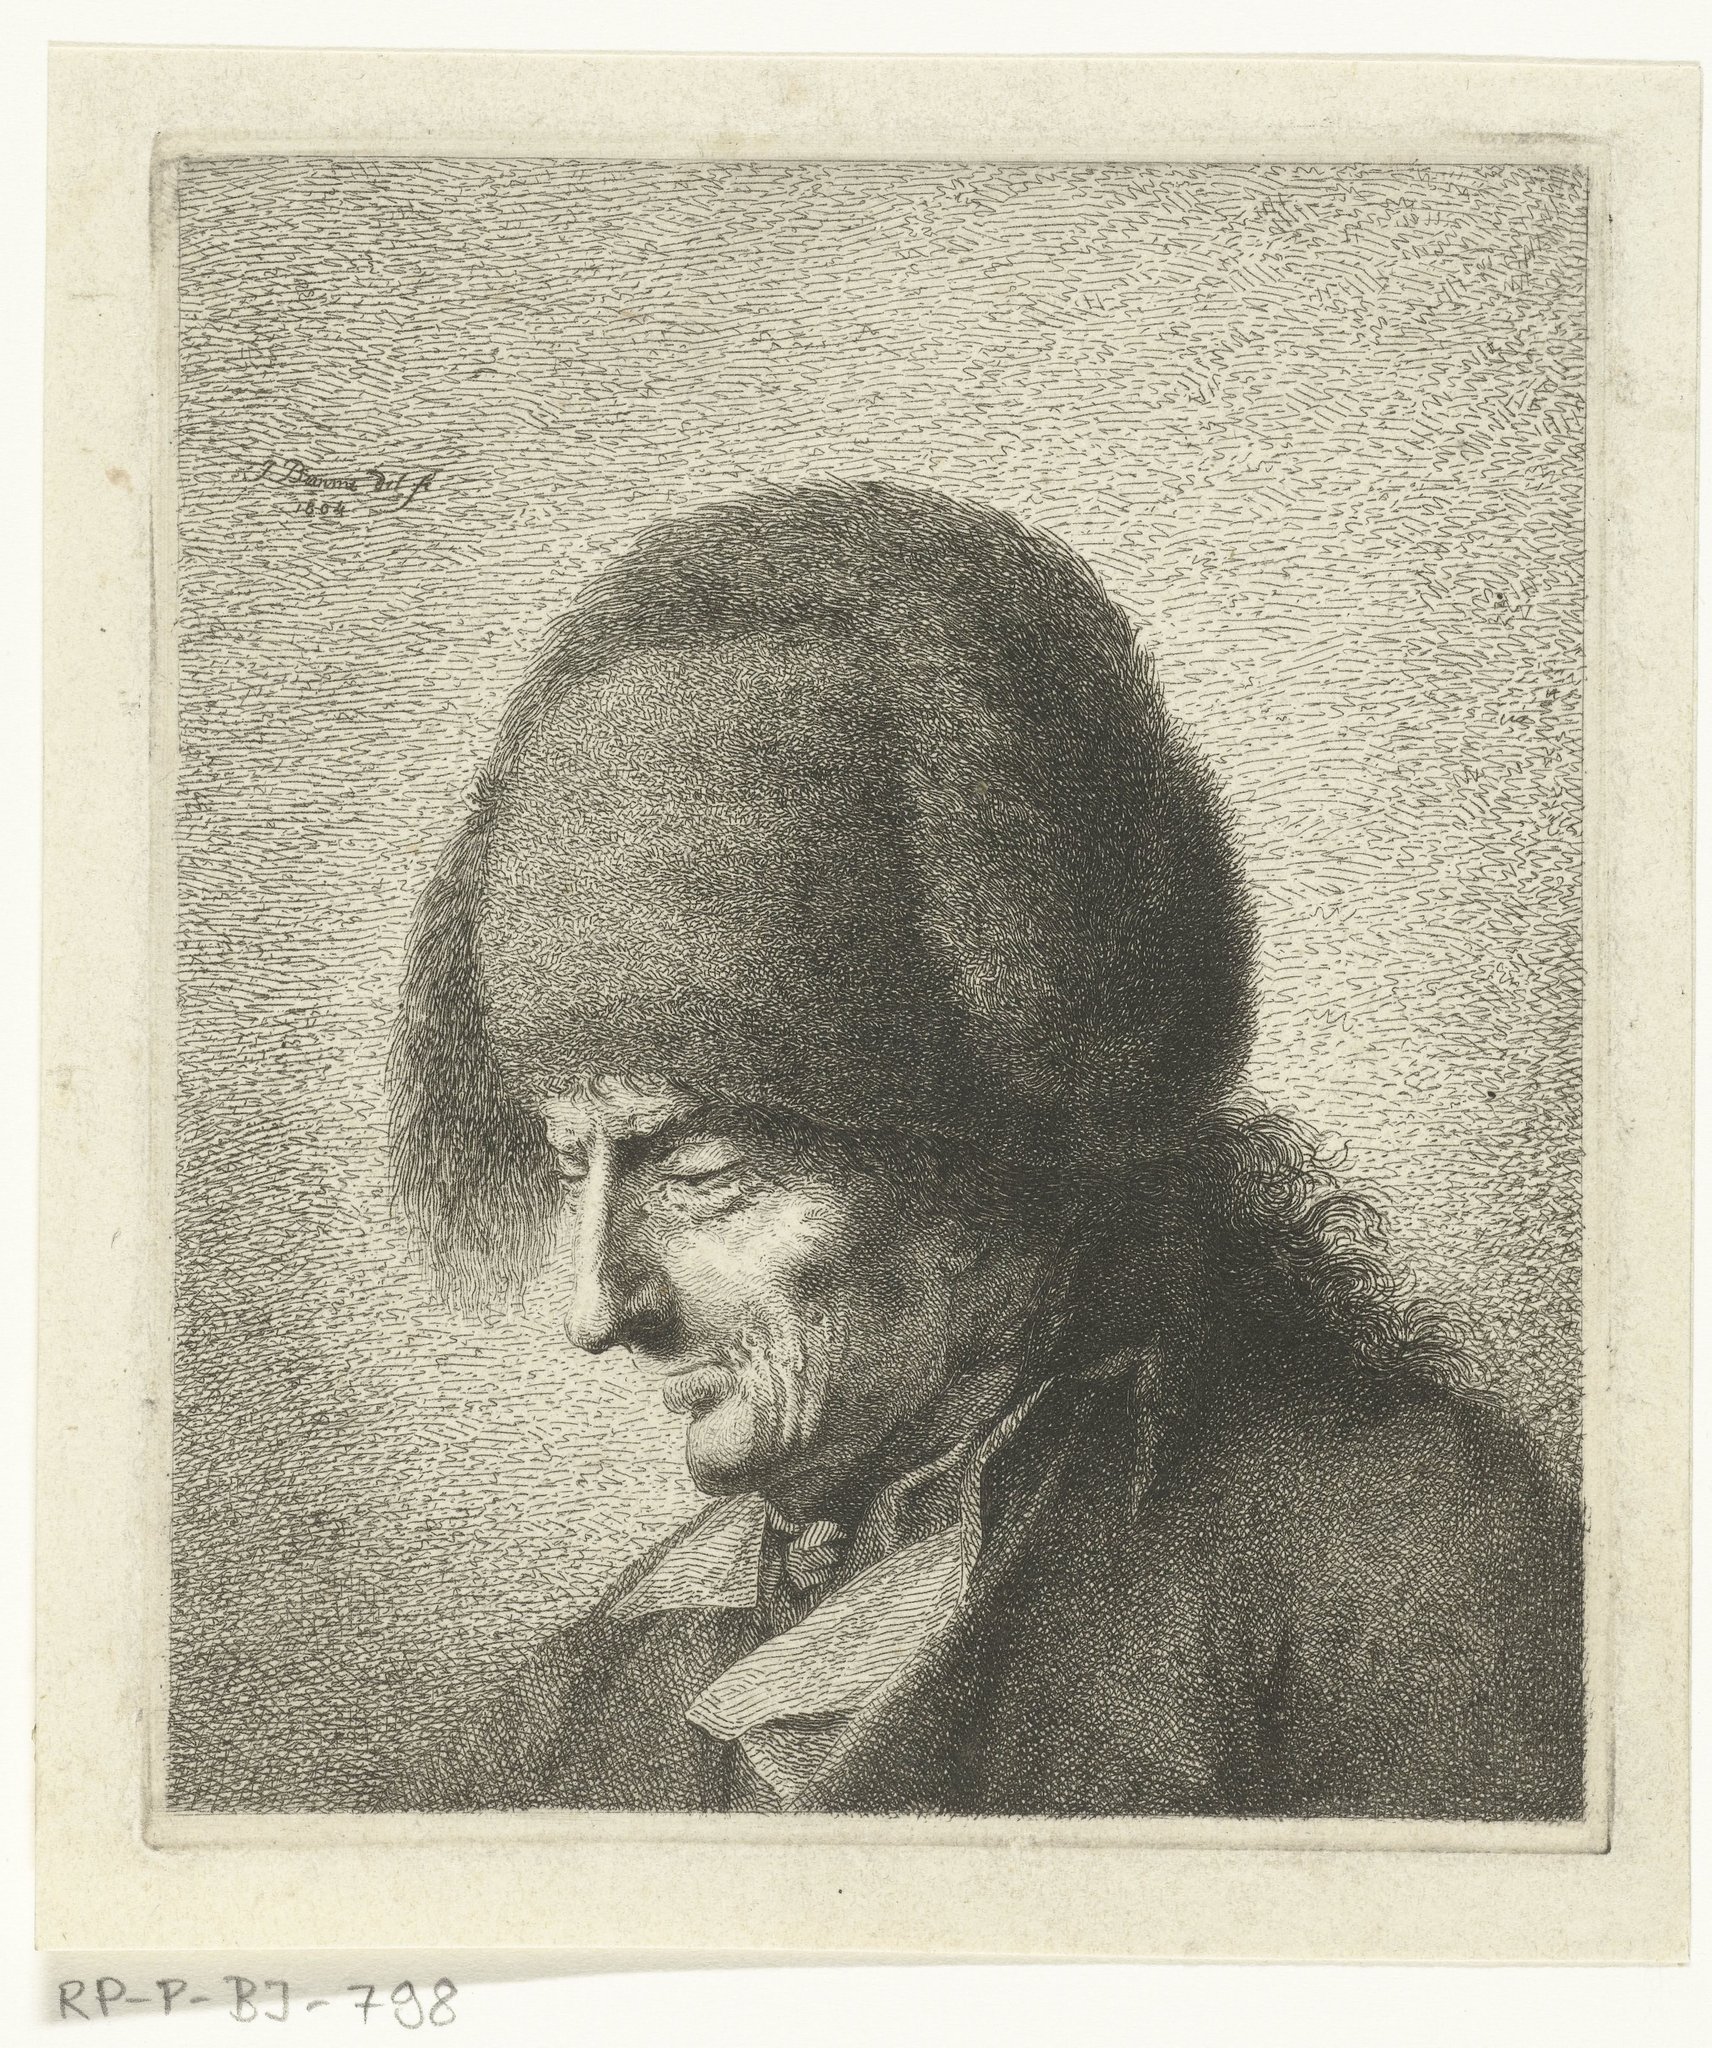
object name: print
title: Portret van een onbekende man met bontmuts, mogelijk genaamd van der Werff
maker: joannes bemme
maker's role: print maker, printer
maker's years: 1775-1841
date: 1804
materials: paper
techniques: etching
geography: rotterdam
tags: head-gear: cap (+ men's clothes), old man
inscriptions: collector's mark: Lugt 2228